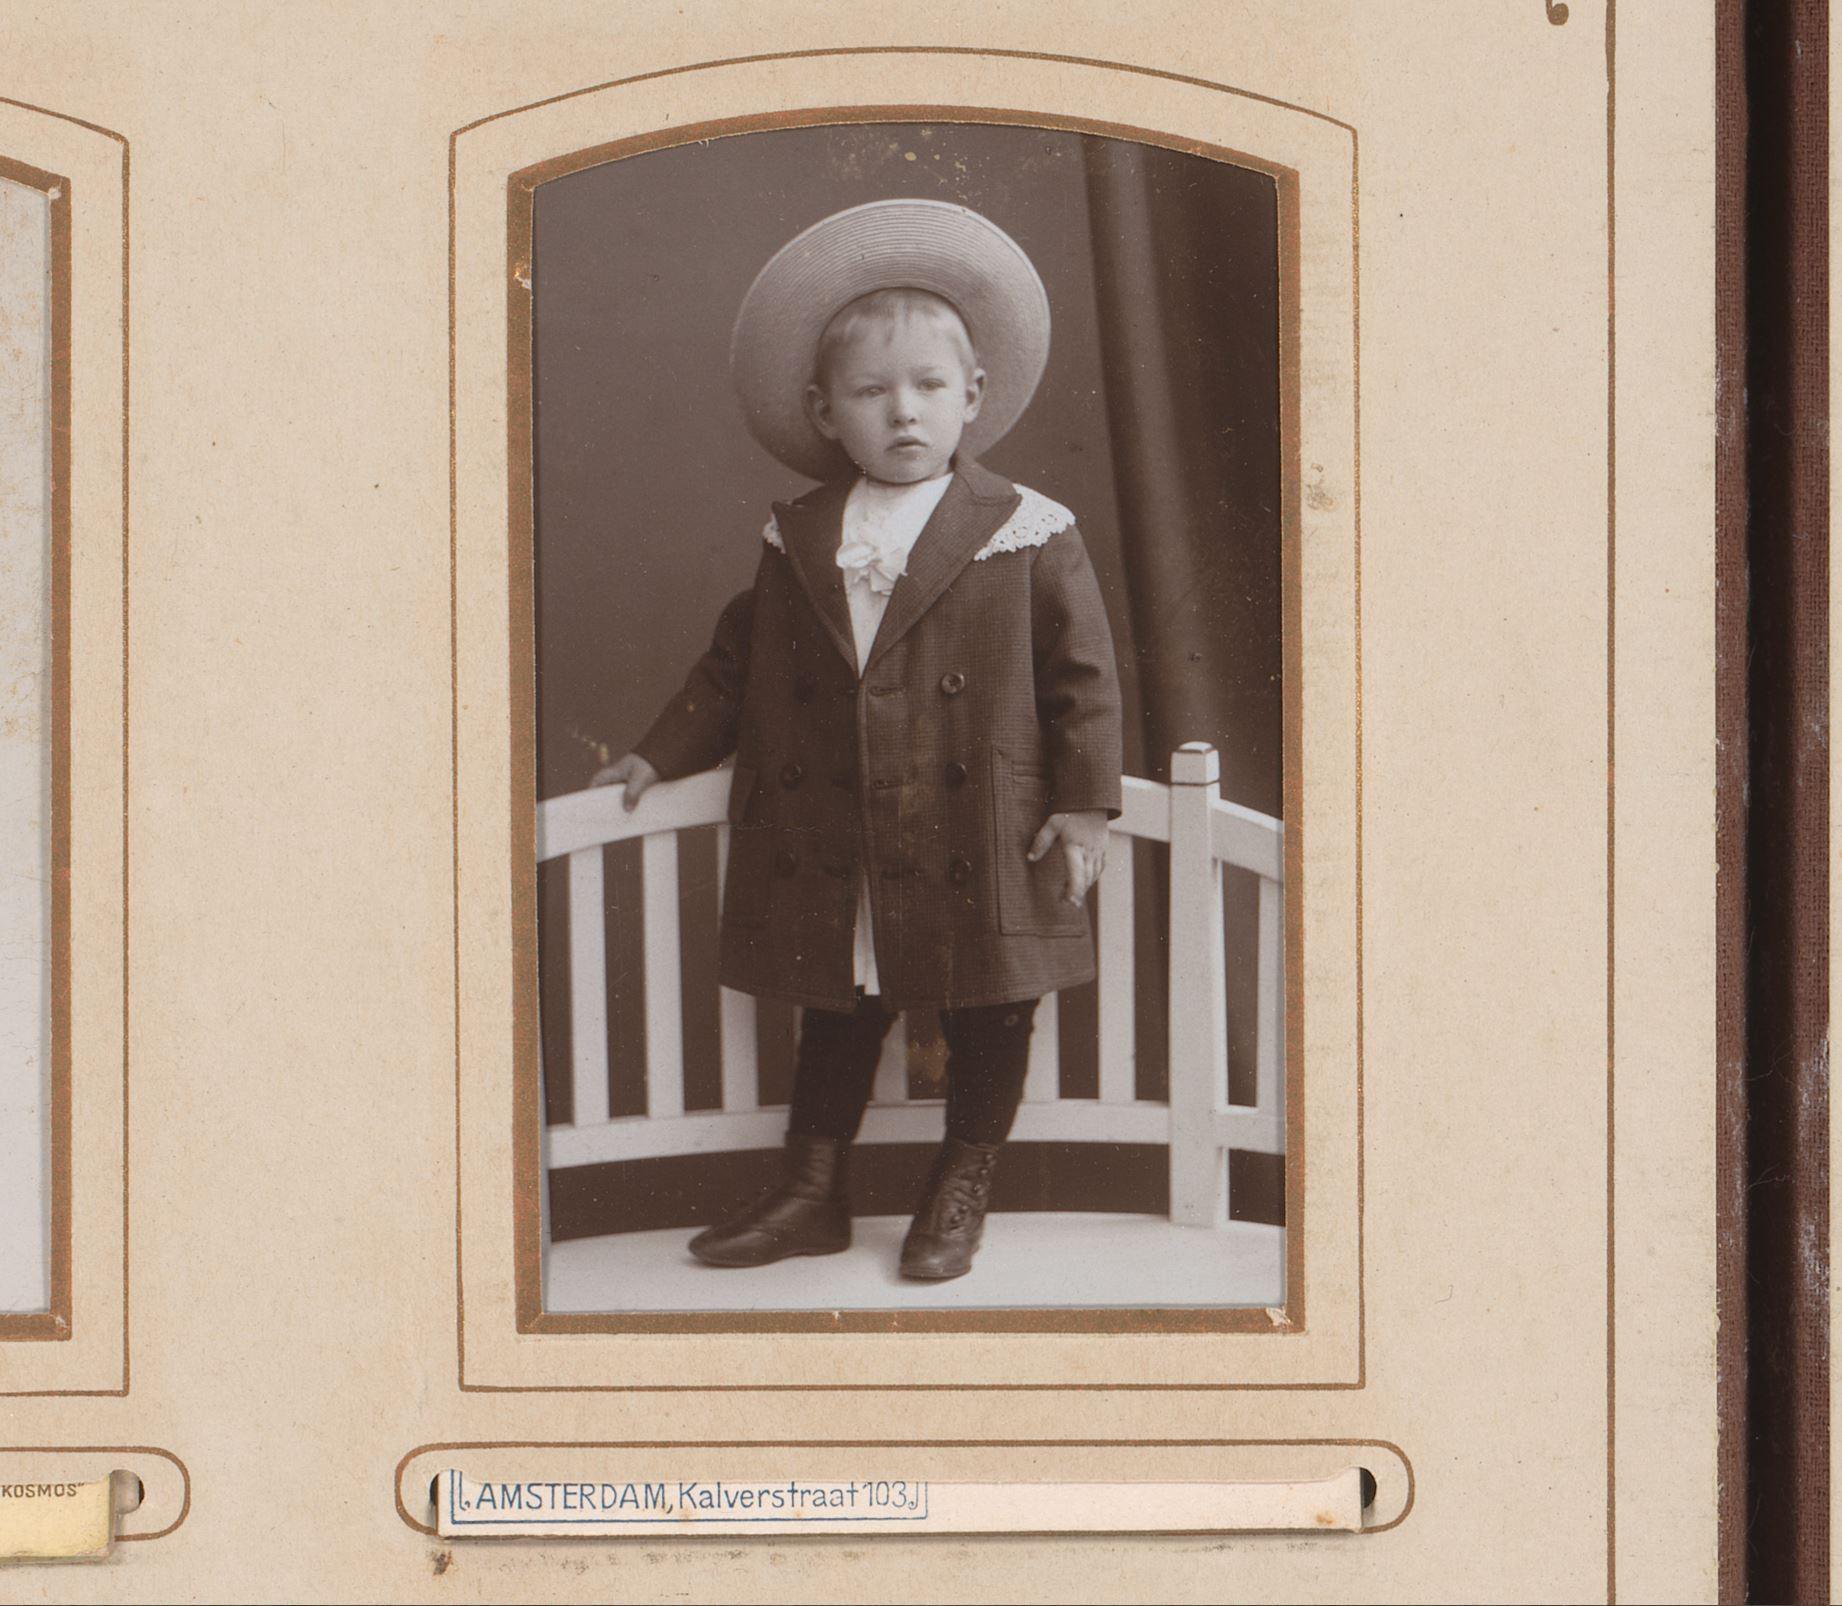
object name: photograph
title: Portret van een jongen met hoed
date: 1911-1932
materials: cardboard, photographic support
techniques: collodion silver print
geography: amsterdam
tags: boy (child between toddler and youth), head-gear: hat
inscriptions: inscription: ‘Atelier Prinses/ Amsterdam, Kalverstraat 103’